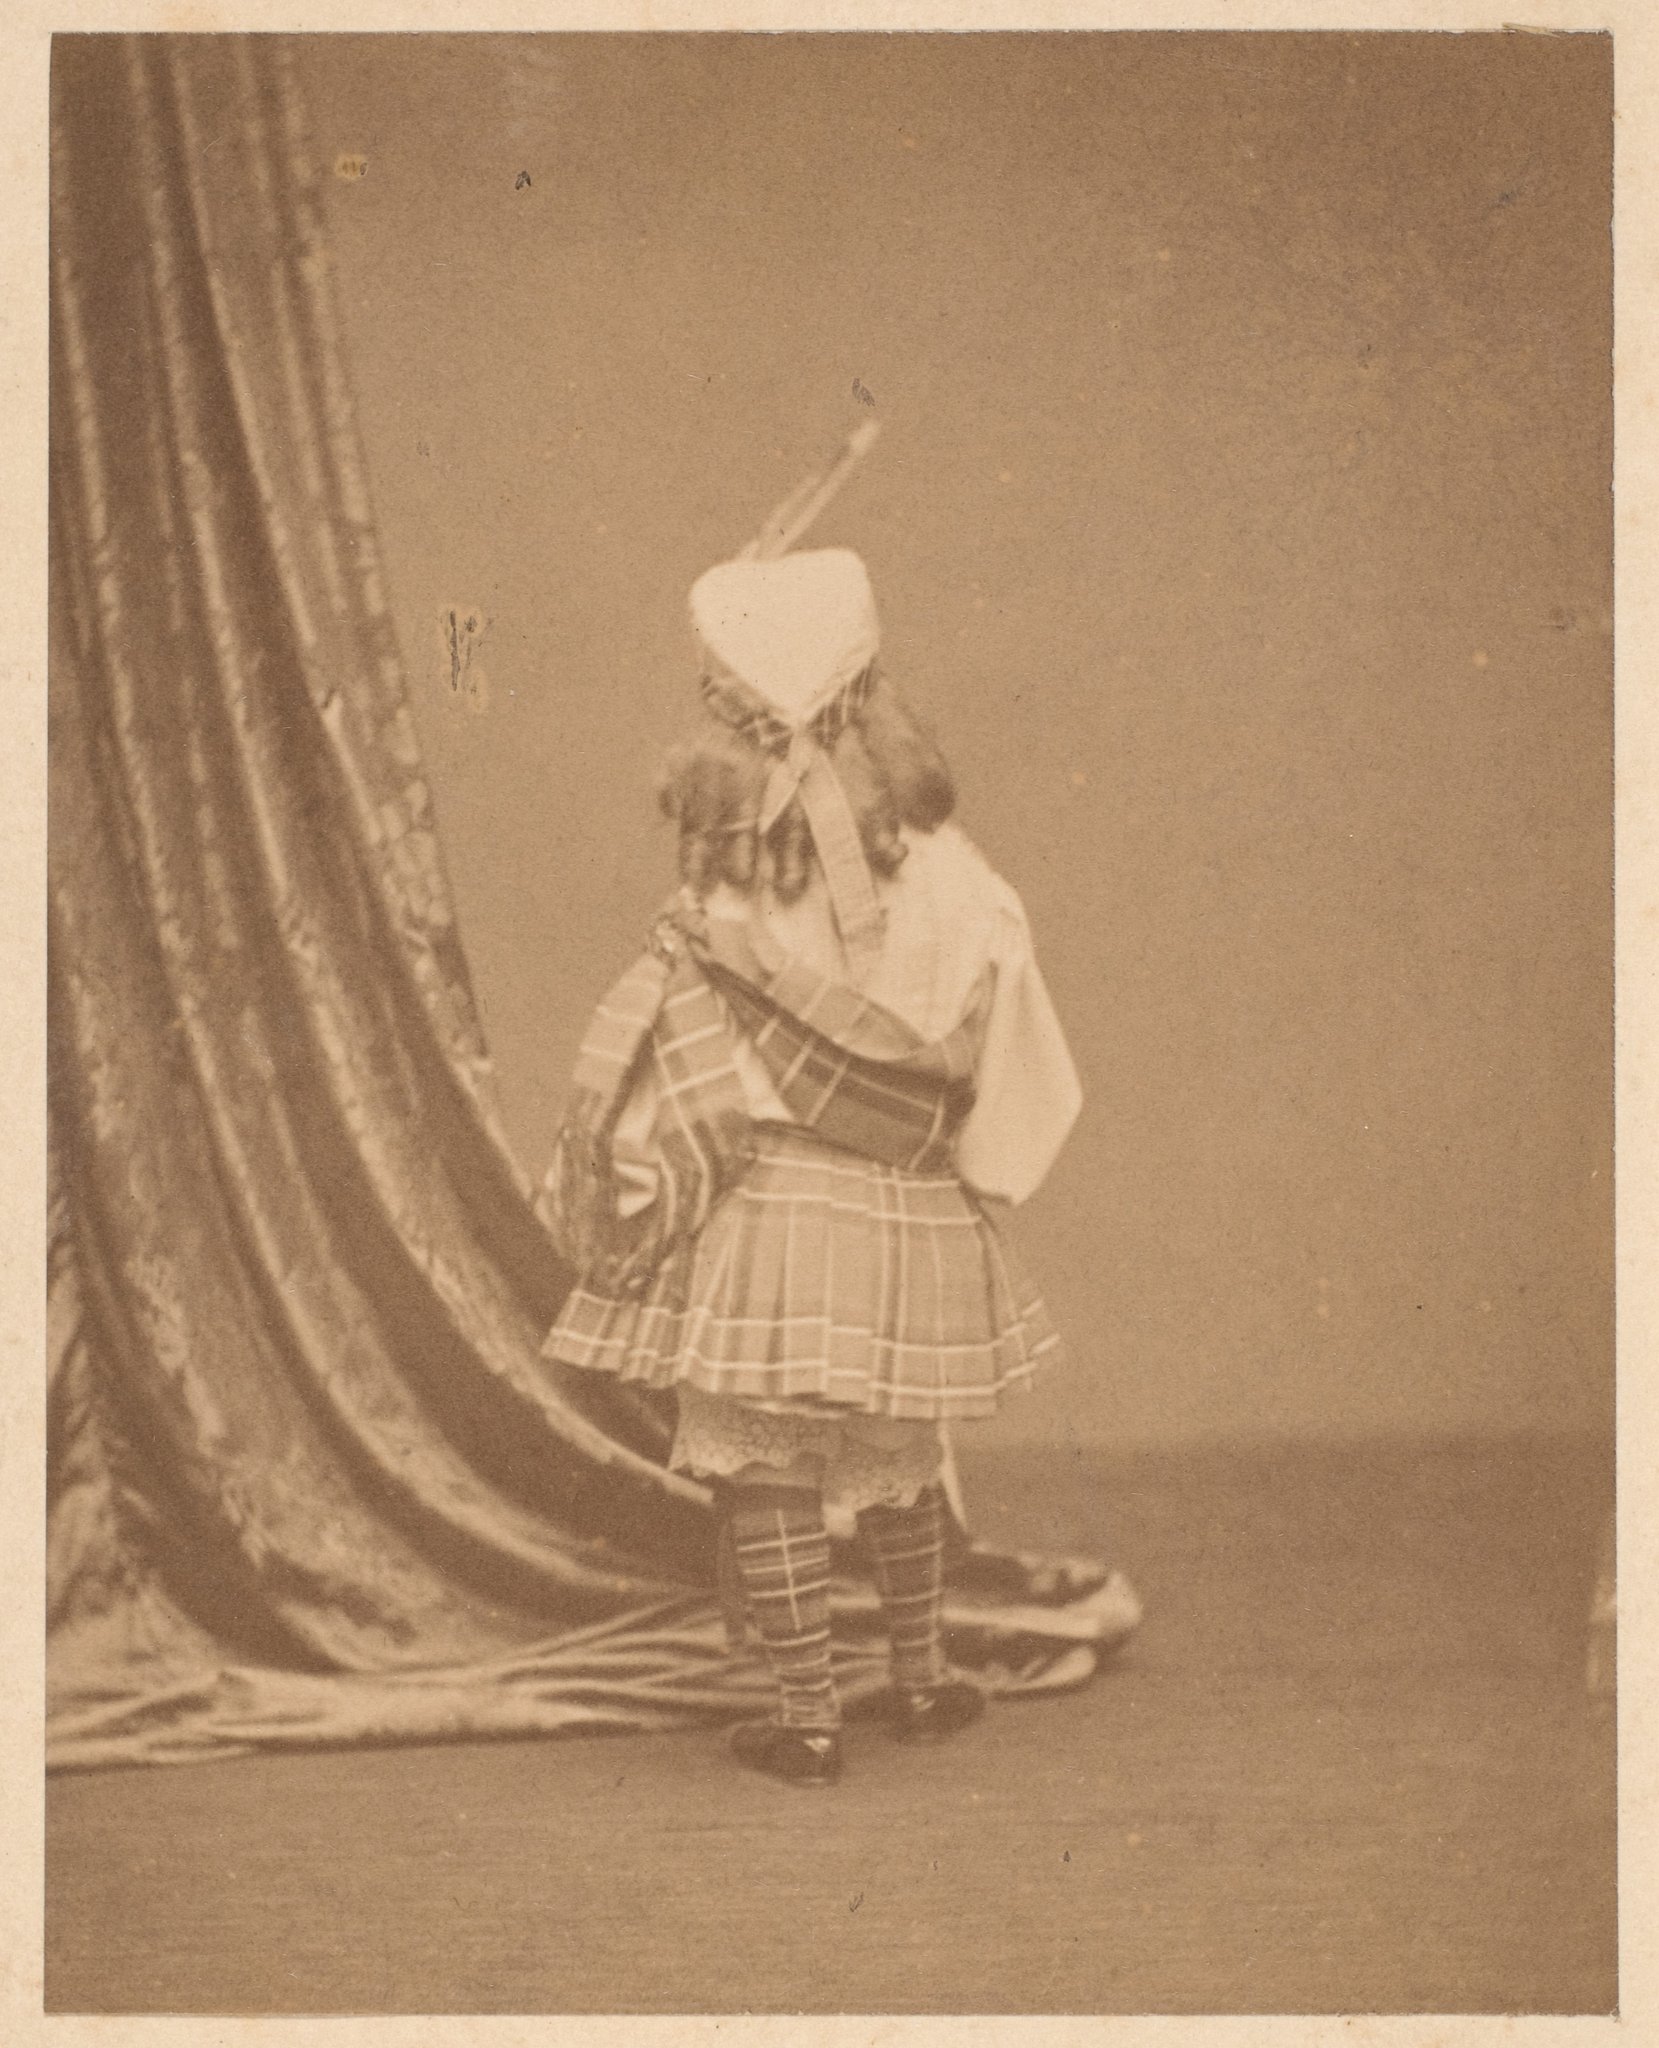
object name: photograph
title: Le dos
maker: pierre-louis pierson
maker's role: artist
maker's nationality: french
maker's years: 1822-1913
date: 1860-1869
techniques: albumen silver print, glass negative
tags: portraits